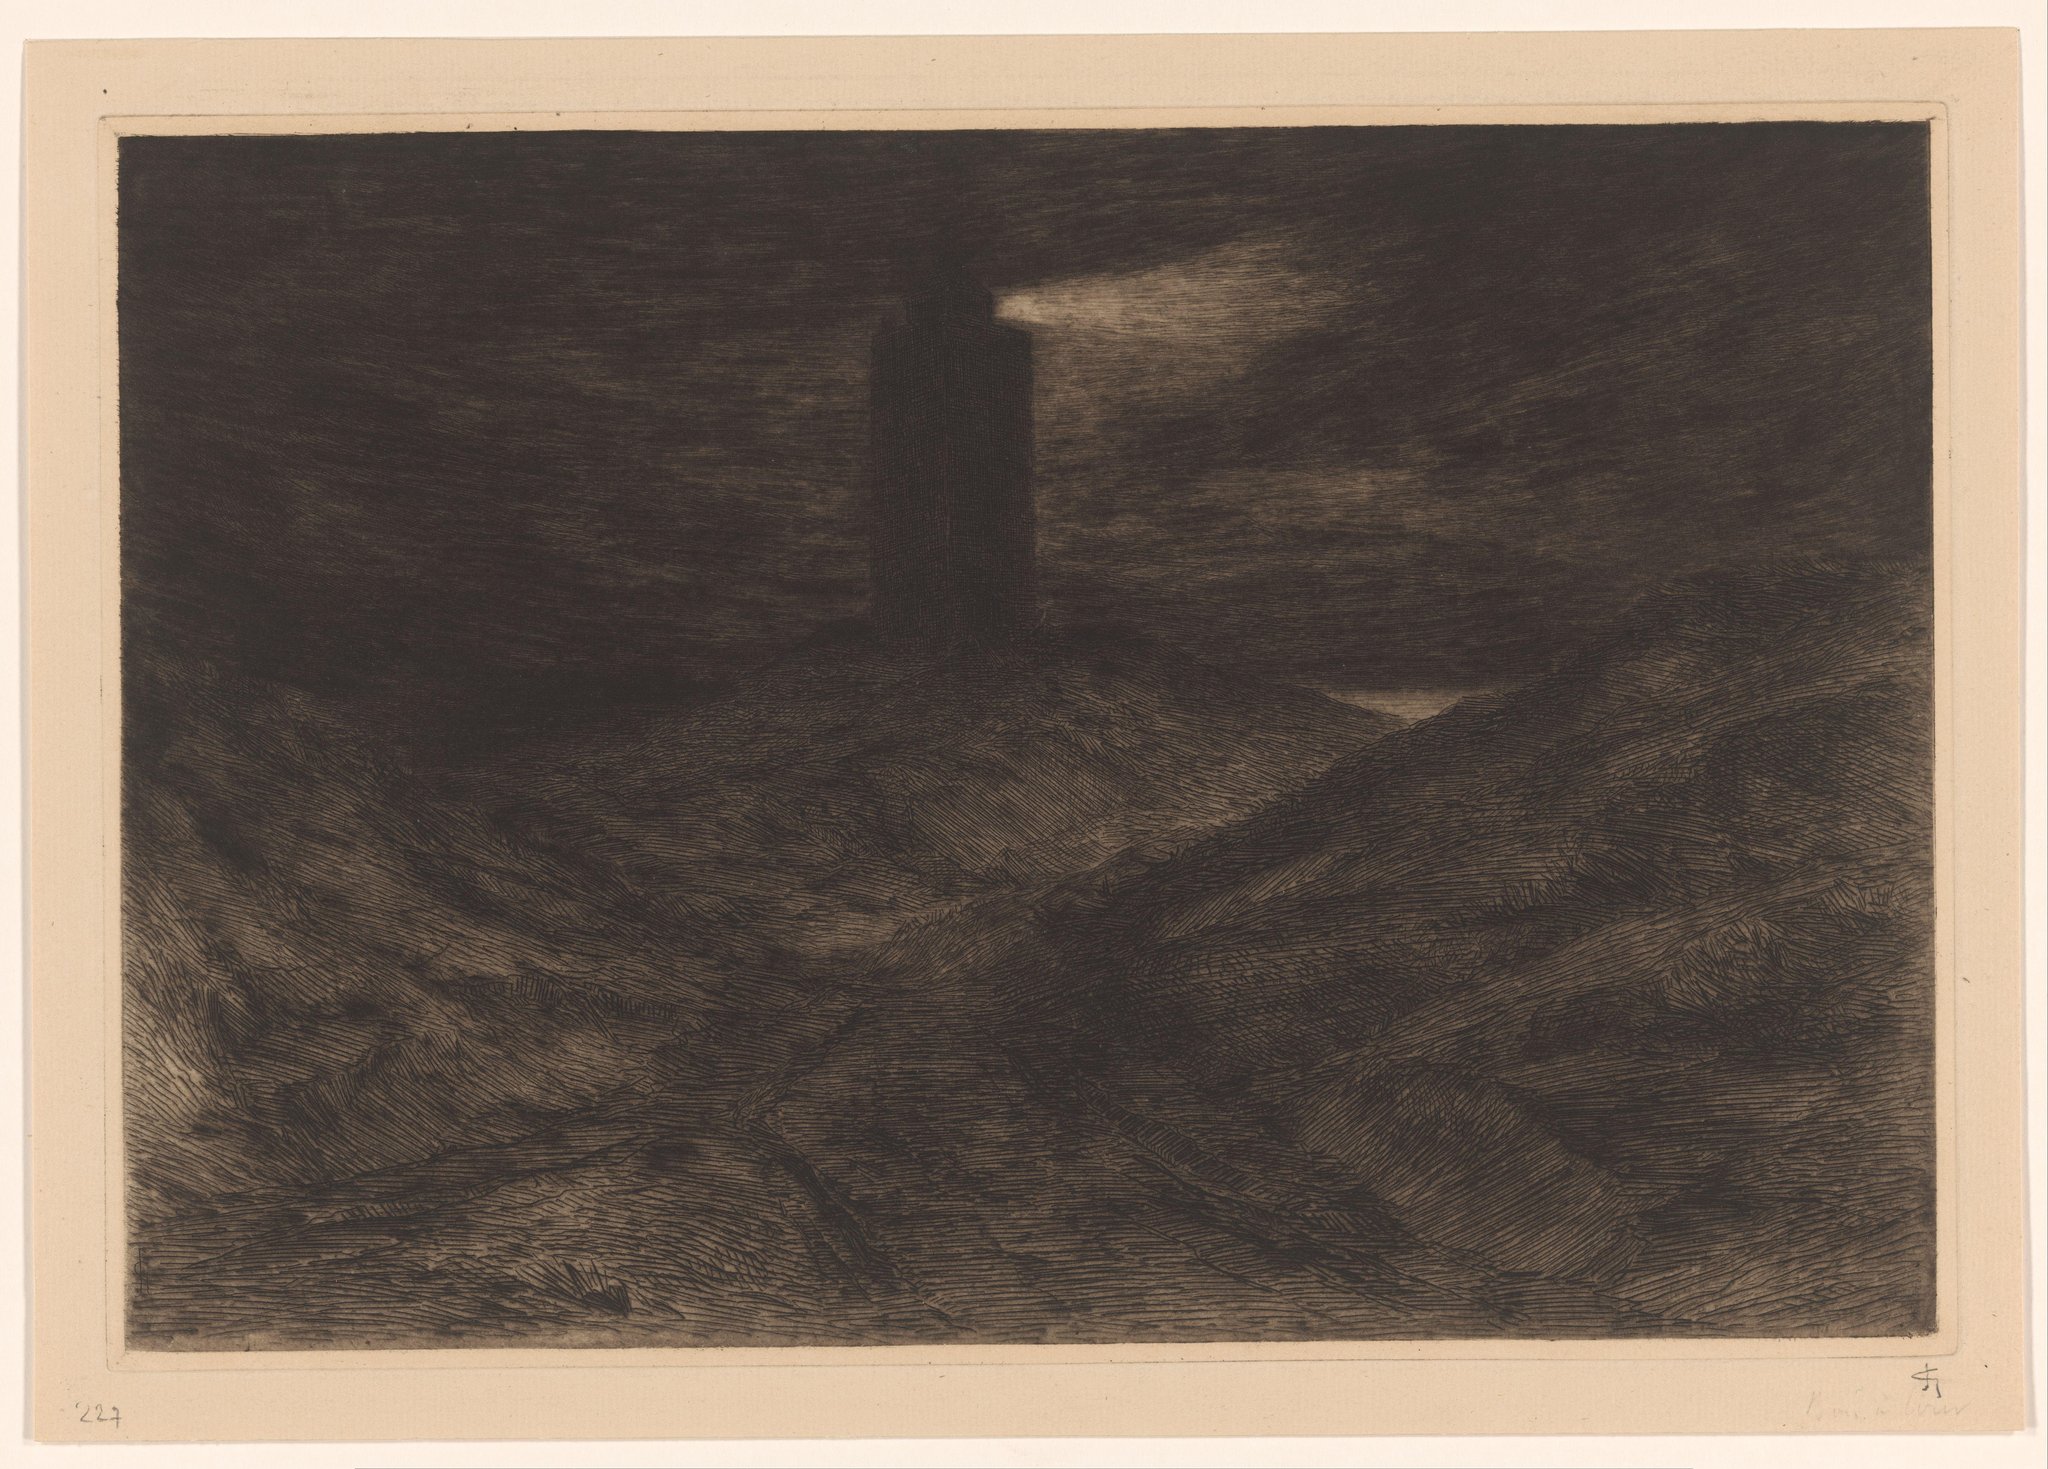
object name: print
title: Vuurtoren van Katwijk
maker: carel nicolaas storm van s-gravesande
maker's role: draughtsman, print maker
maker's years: 1841-1924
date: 1851-1887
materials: paper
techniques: drypoint, intaglio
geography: netherlands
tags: lighthouse, lightship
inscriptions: collector's mark: Lugt 2228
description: Donker duinlandschap met in het midden de vuurtoren van Katwijk.